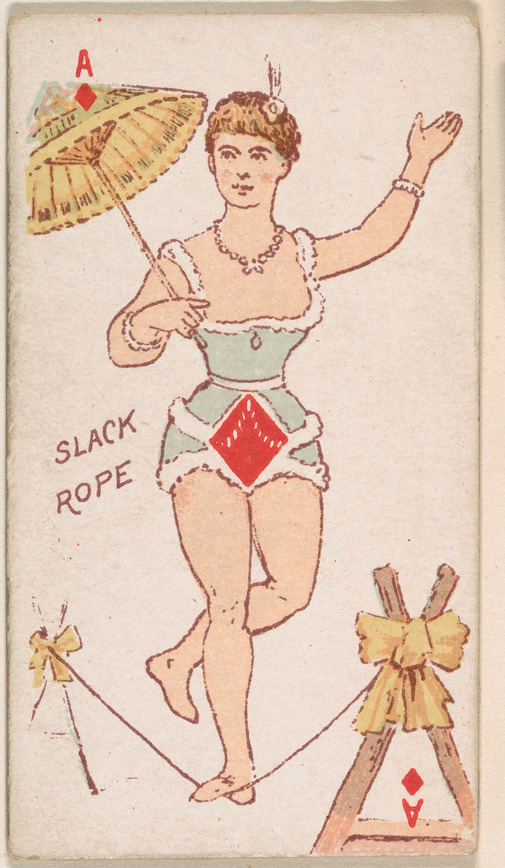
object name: print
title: Ace of Diamonds, Slack Rope, from Harlequin Cards, 2nd Series (N220) issued by Kinney Bros.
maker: kinney brothers tobacco company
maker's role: publisher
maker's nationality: american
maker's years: 1869-2011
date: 1889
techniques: color lithograph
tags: women,playing cards